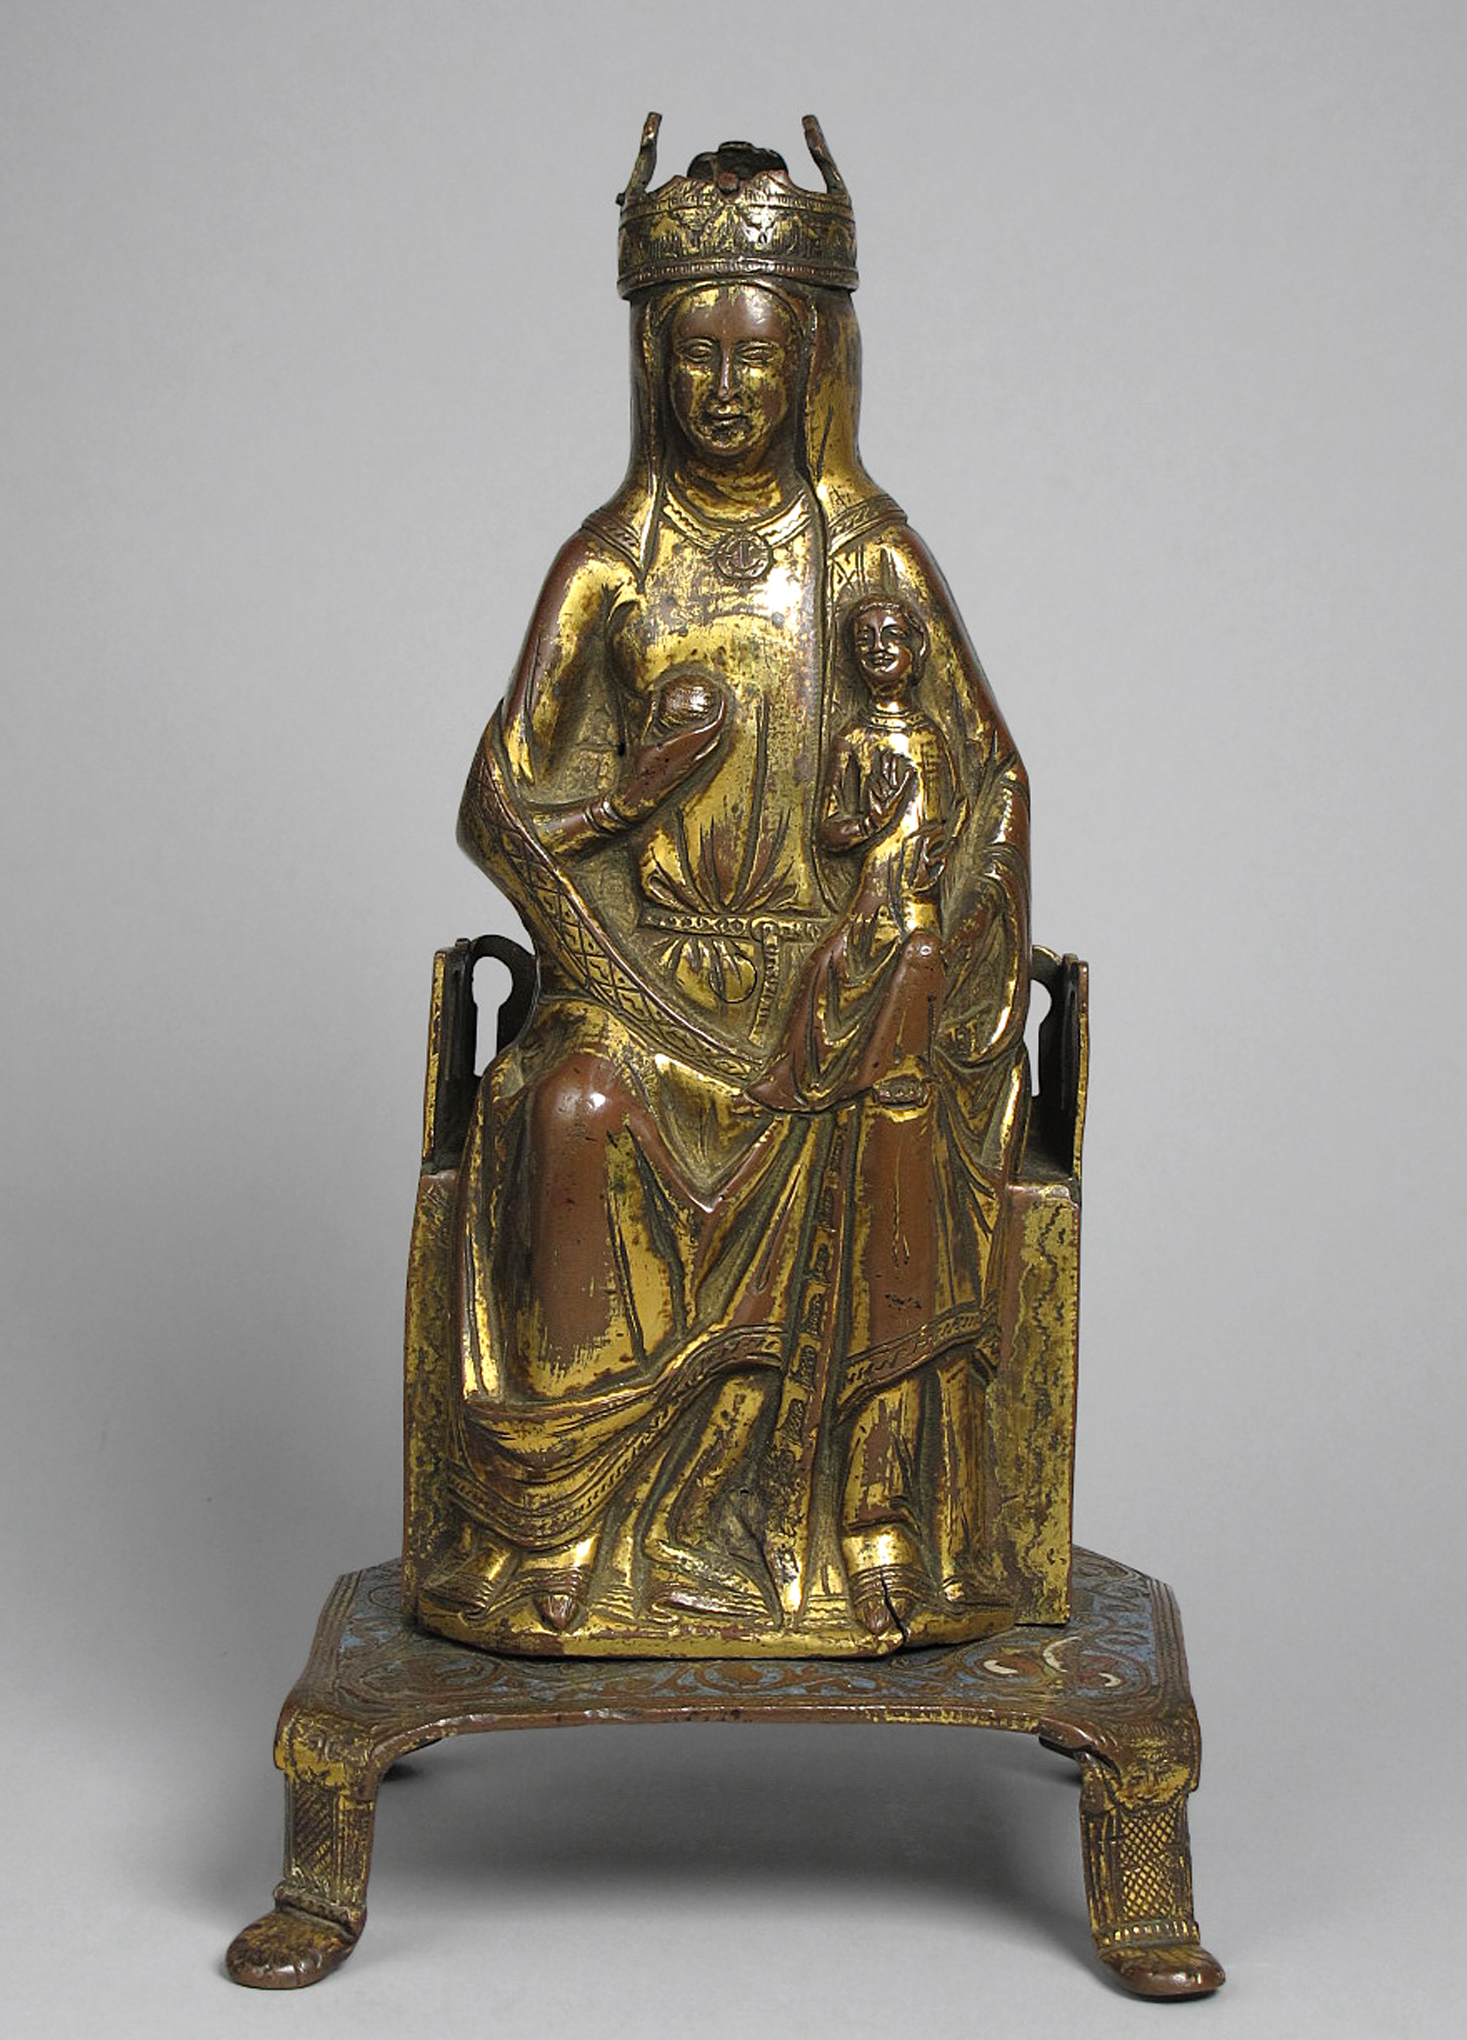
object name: reliquary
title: Seated Virgin and Child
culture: french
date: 1234-1266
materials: gilt copper, enamel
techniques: enamel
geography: france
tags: madonna and child